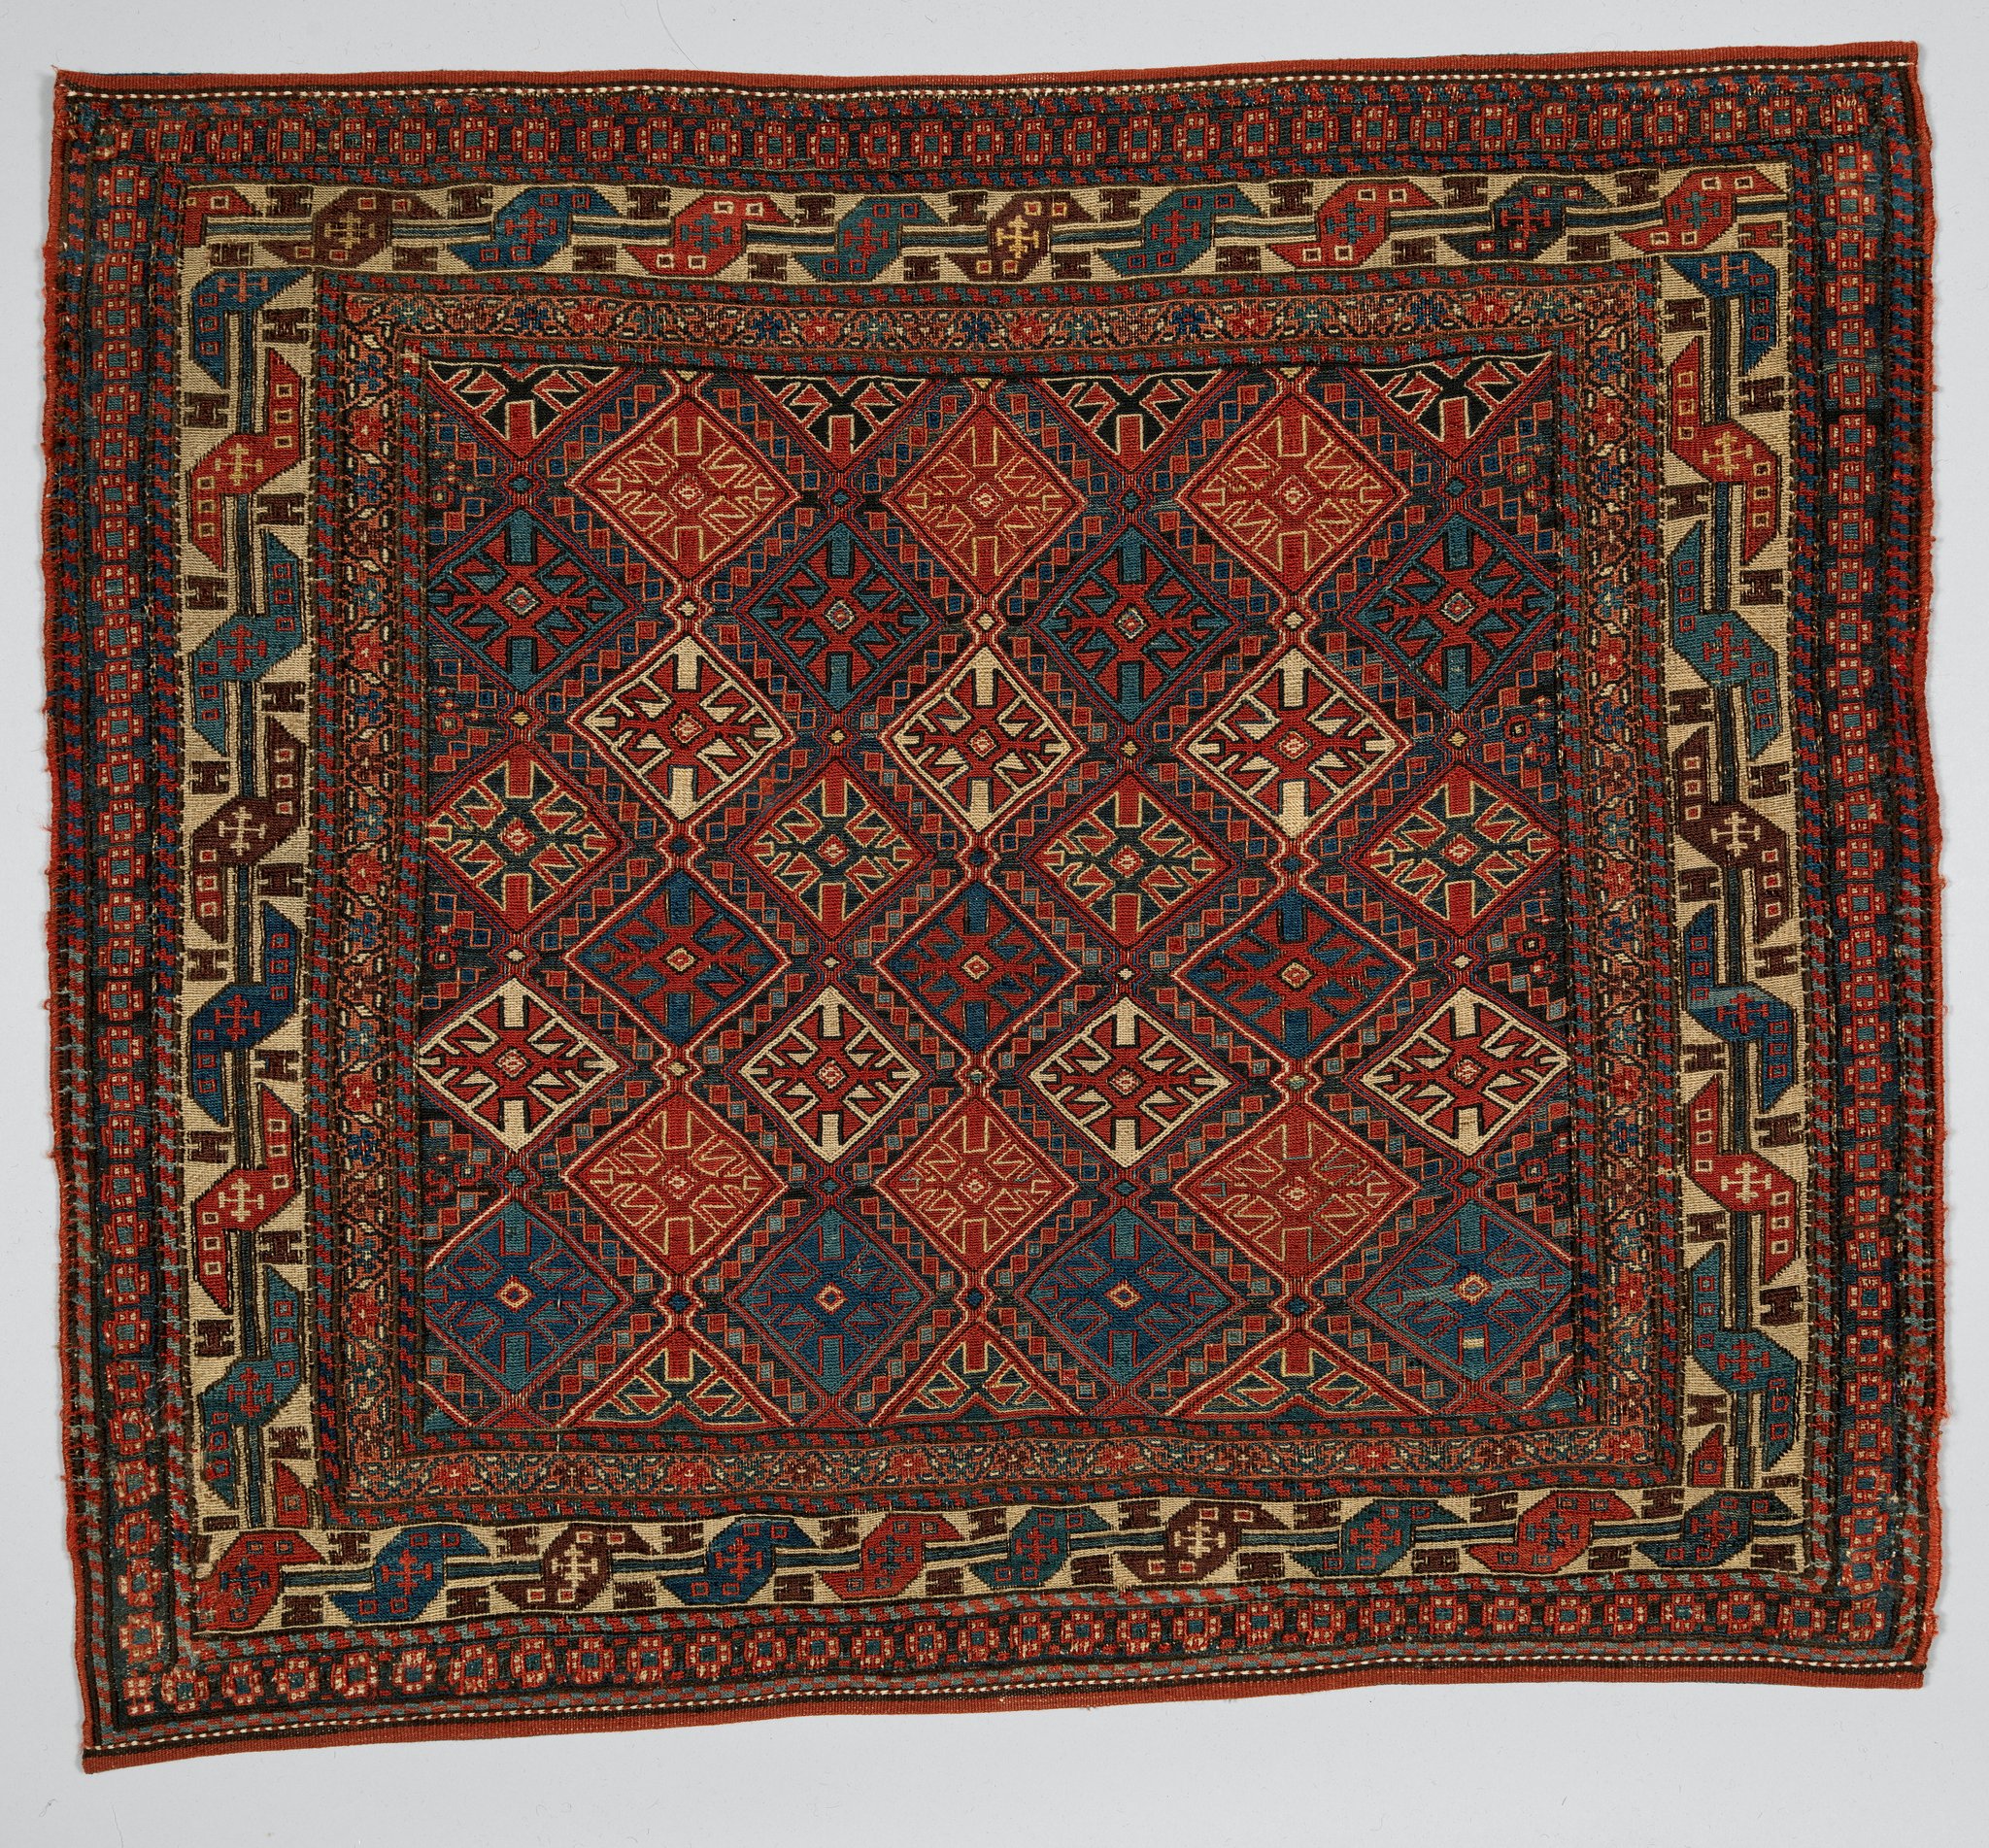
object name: saddle bag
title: Face of Half a Double Saddle Bag (Khorjin)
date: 1825-1875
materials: wool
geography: northwestern iran